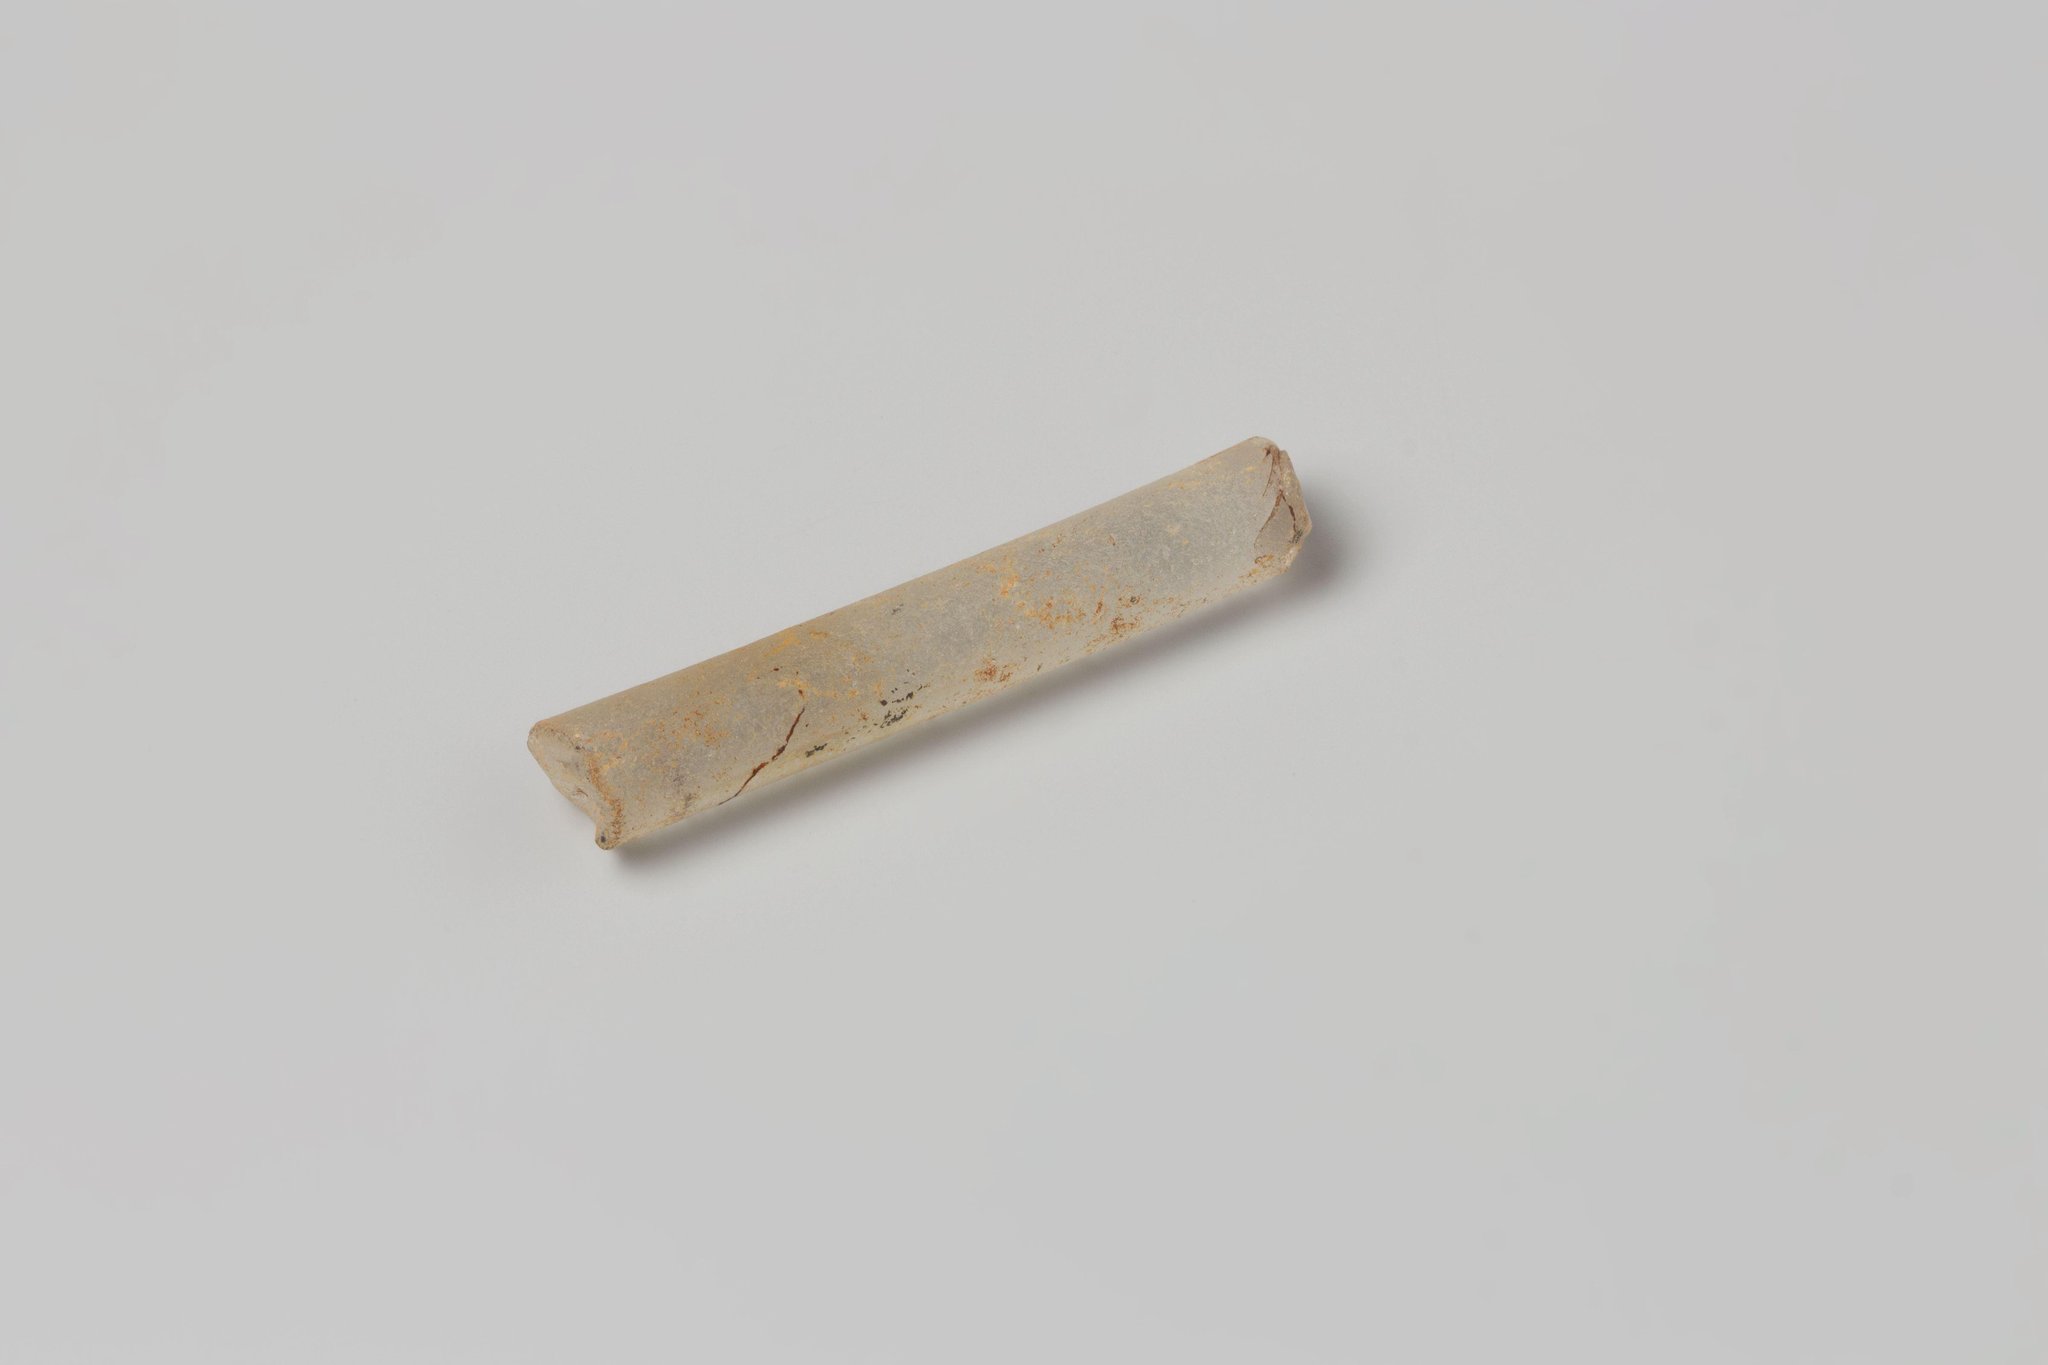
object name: drinking glass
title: Fragment rechte steel van glas uit het wrak van de Oost-Indiëvaarder Hollandia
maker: Anonymous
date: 1700-1743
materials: glass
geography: netherlands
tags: verenigde oostindische compagnie, hollandia (schip), annet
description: Glass, stem glass, stems, plain; fragm, straight, circular in section solid.